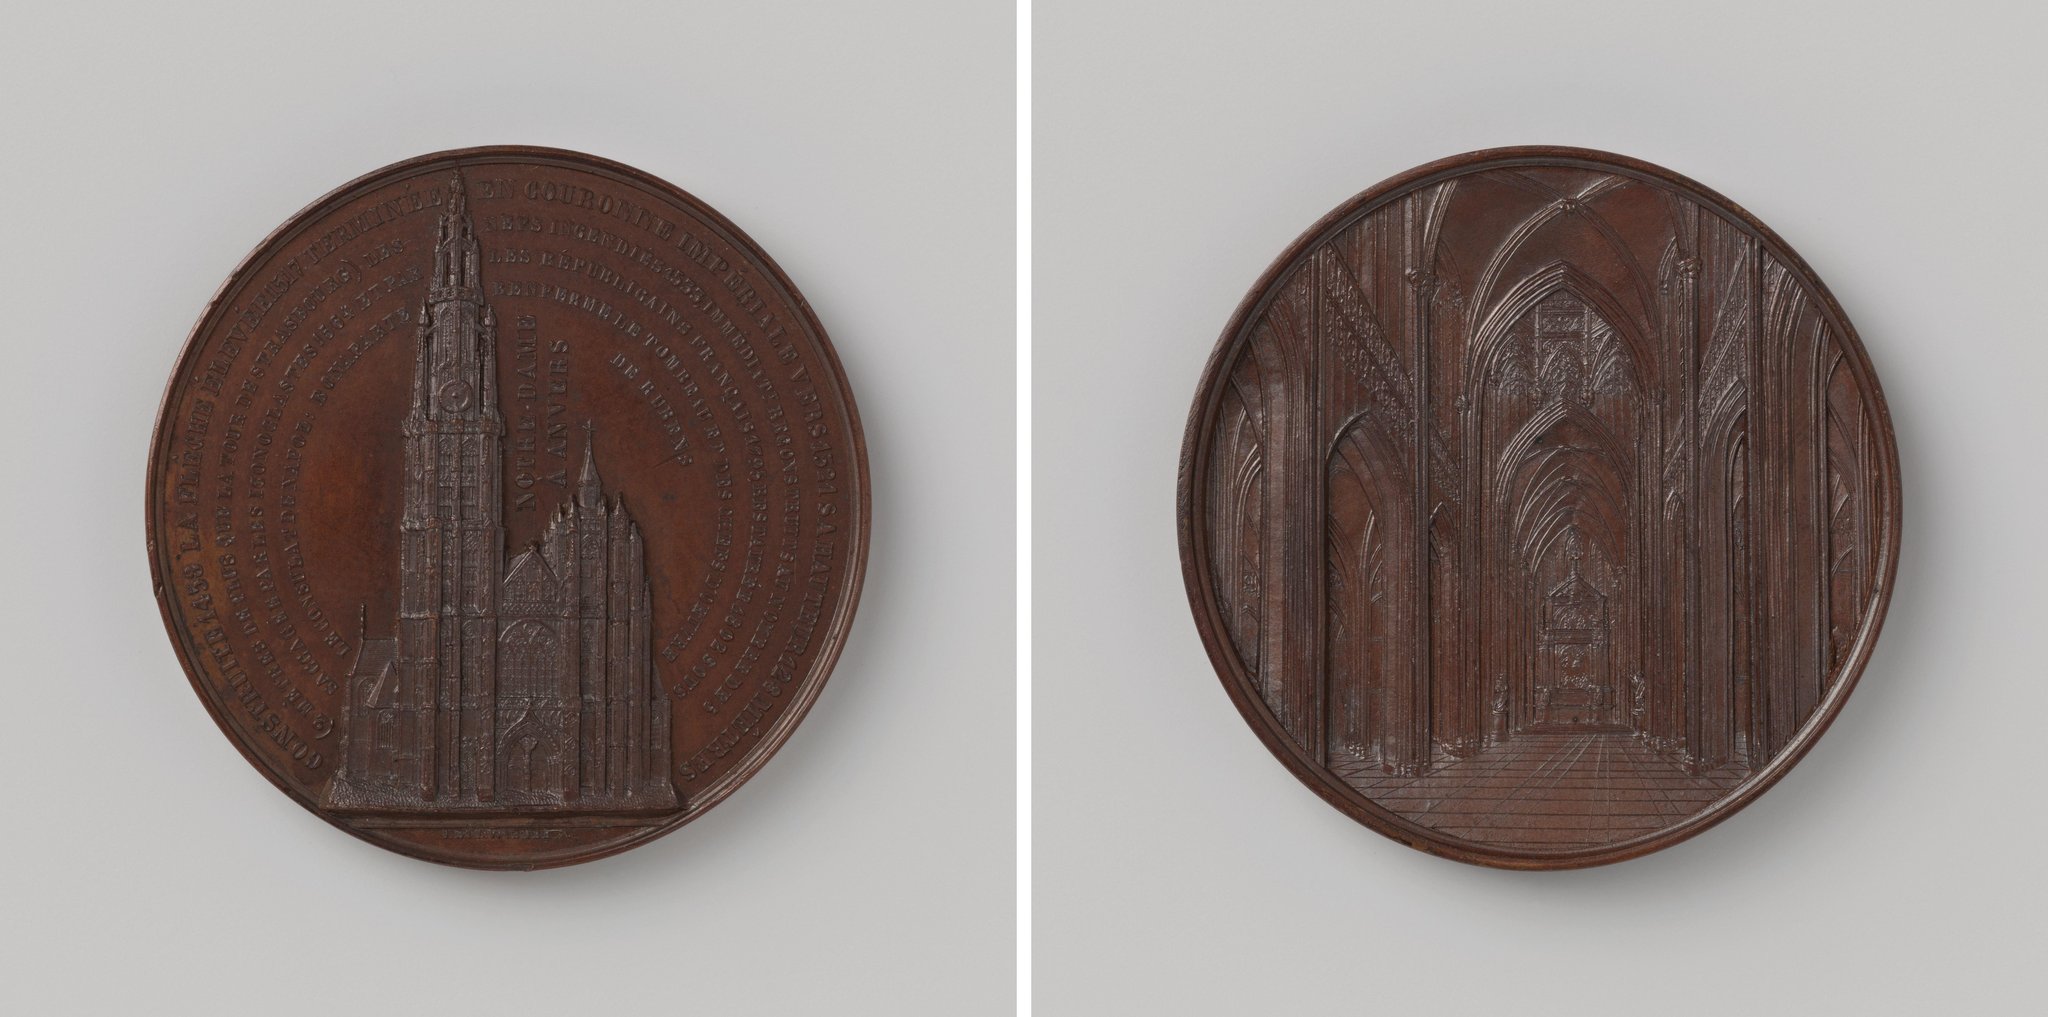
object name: history medal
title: Notre Dame te Antwerpen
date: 1845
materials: bronze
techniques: striking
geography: brussels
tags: onze-lieve-vrouwekathedraal (antwerpen)